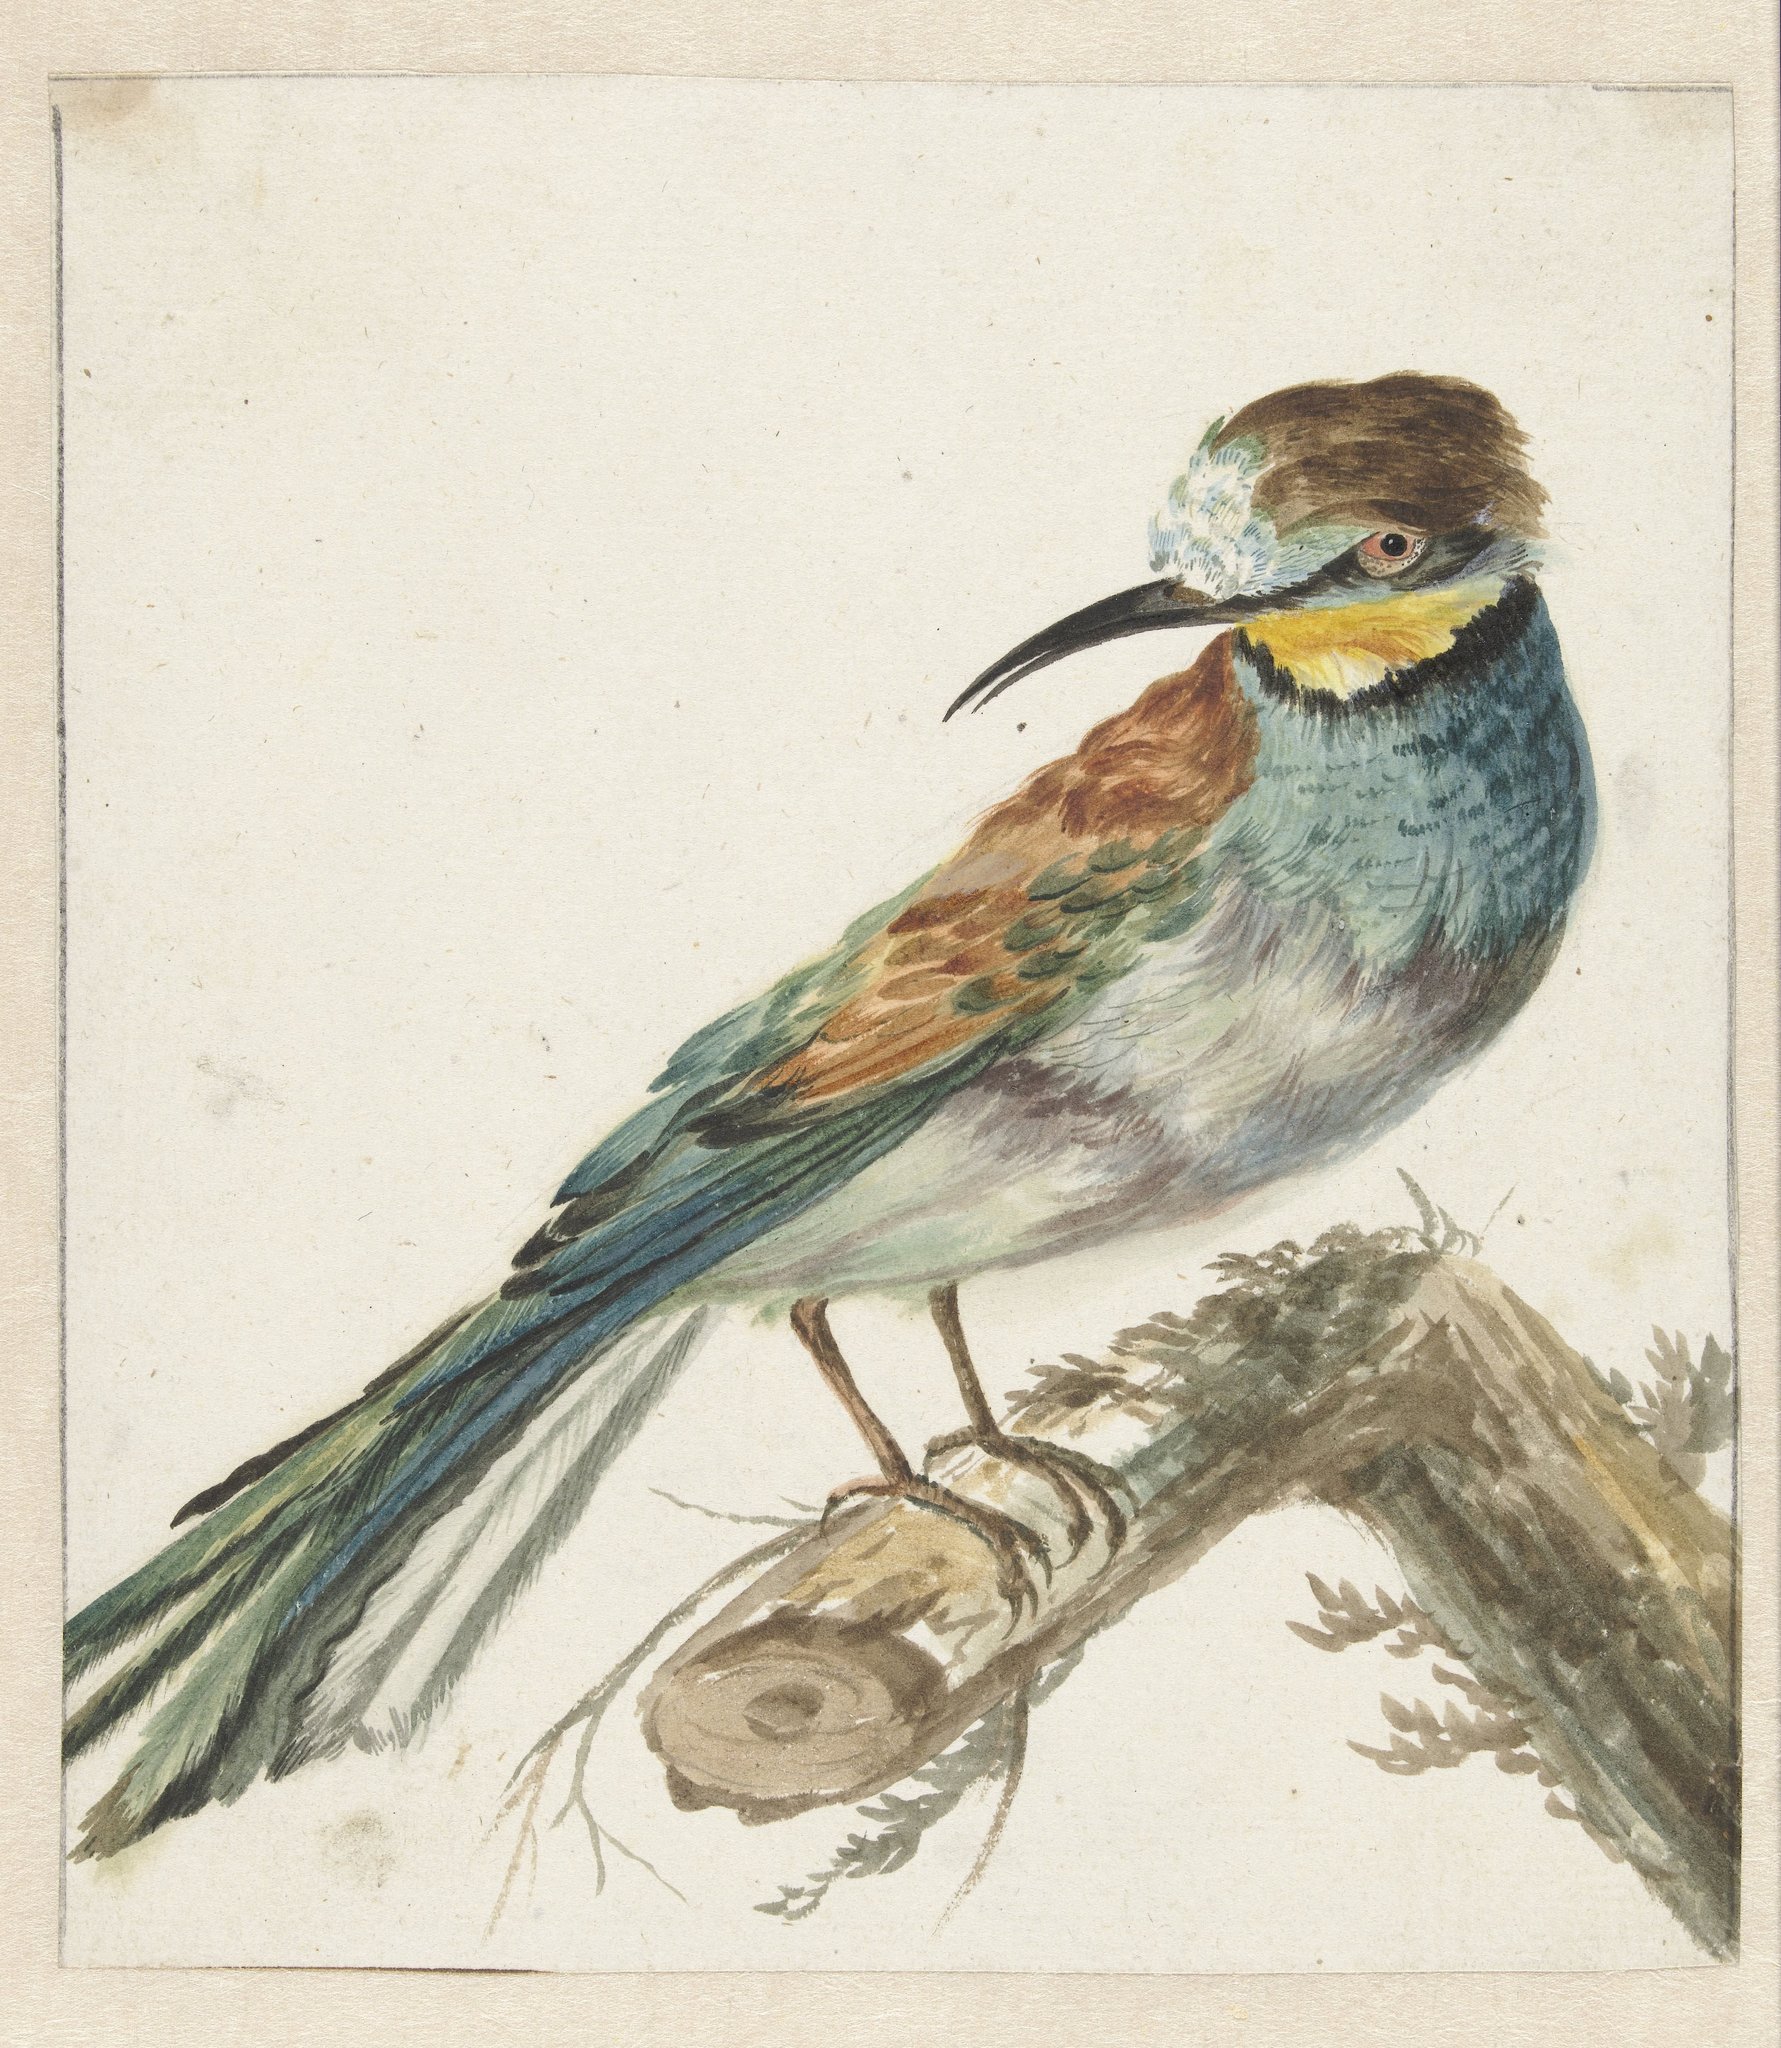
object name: drawing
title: Bijeneter (Merops apiaster)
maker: jan weenix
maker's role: draughtsman, painter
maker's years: 1640-1719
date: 1650-1719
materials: paper, watercolor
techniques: brush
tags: other birds: bee-eater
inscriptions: : ‘Bijenvanger van Ceylon’